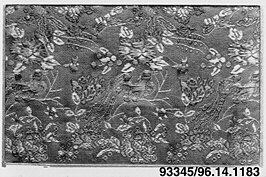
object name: piece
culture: japanese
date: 1701-1900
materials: silk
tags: flowers